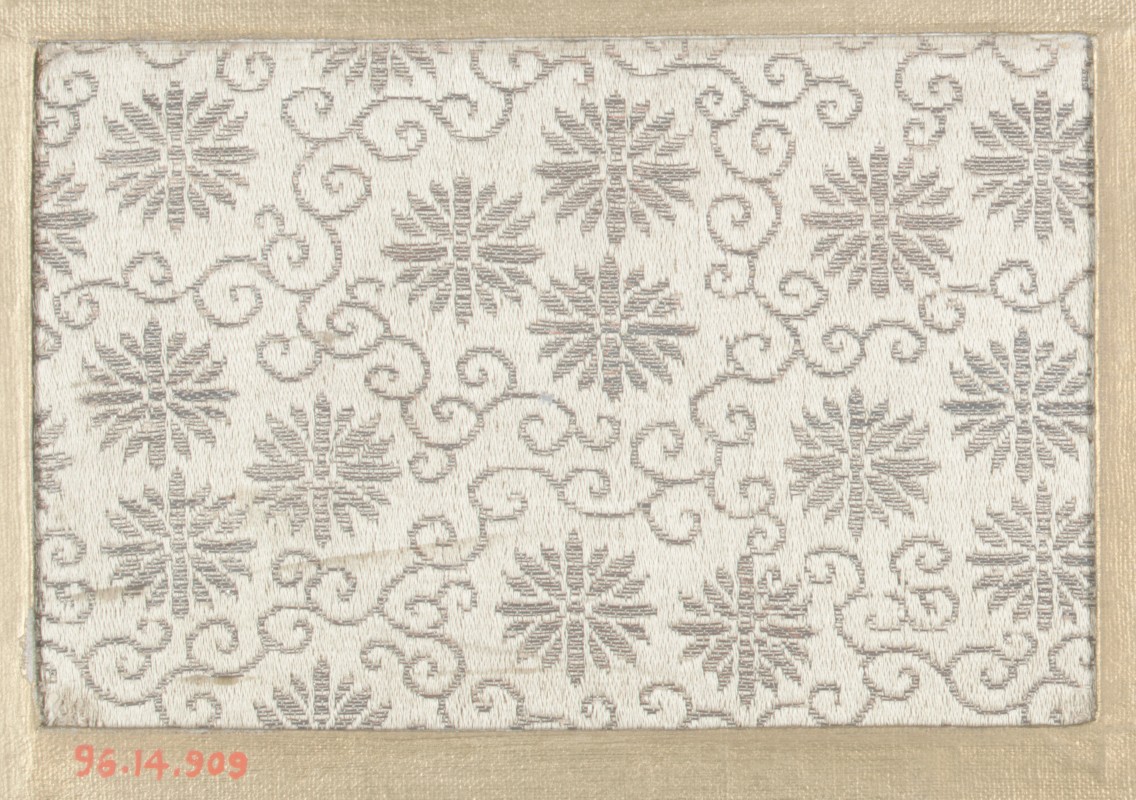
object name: piece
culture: japanese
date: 1701-1900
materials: silk